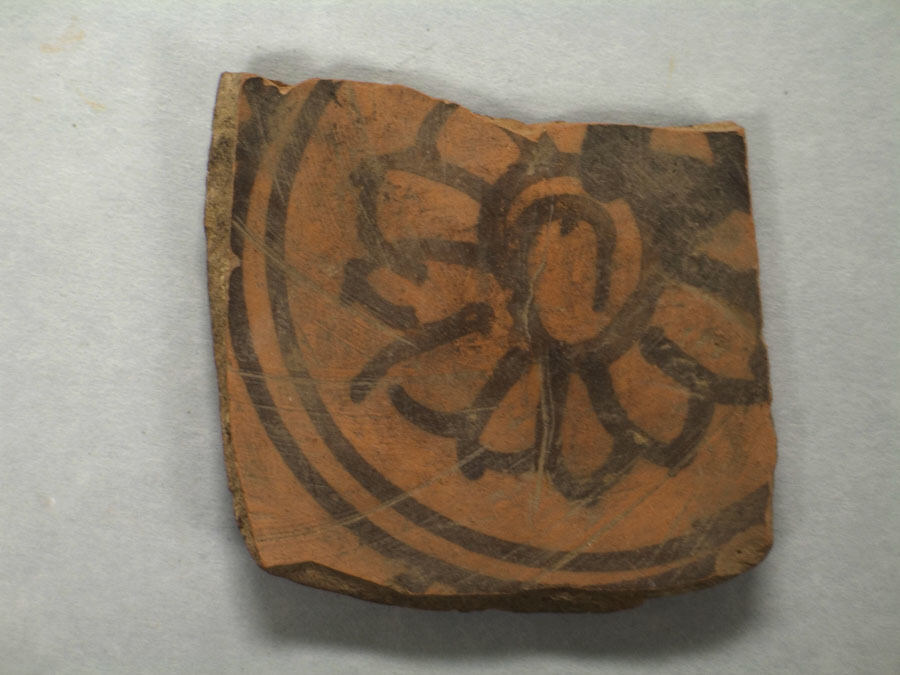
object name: shard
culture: pakistani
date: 301-500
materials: terracotta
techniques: painting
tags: gandhara